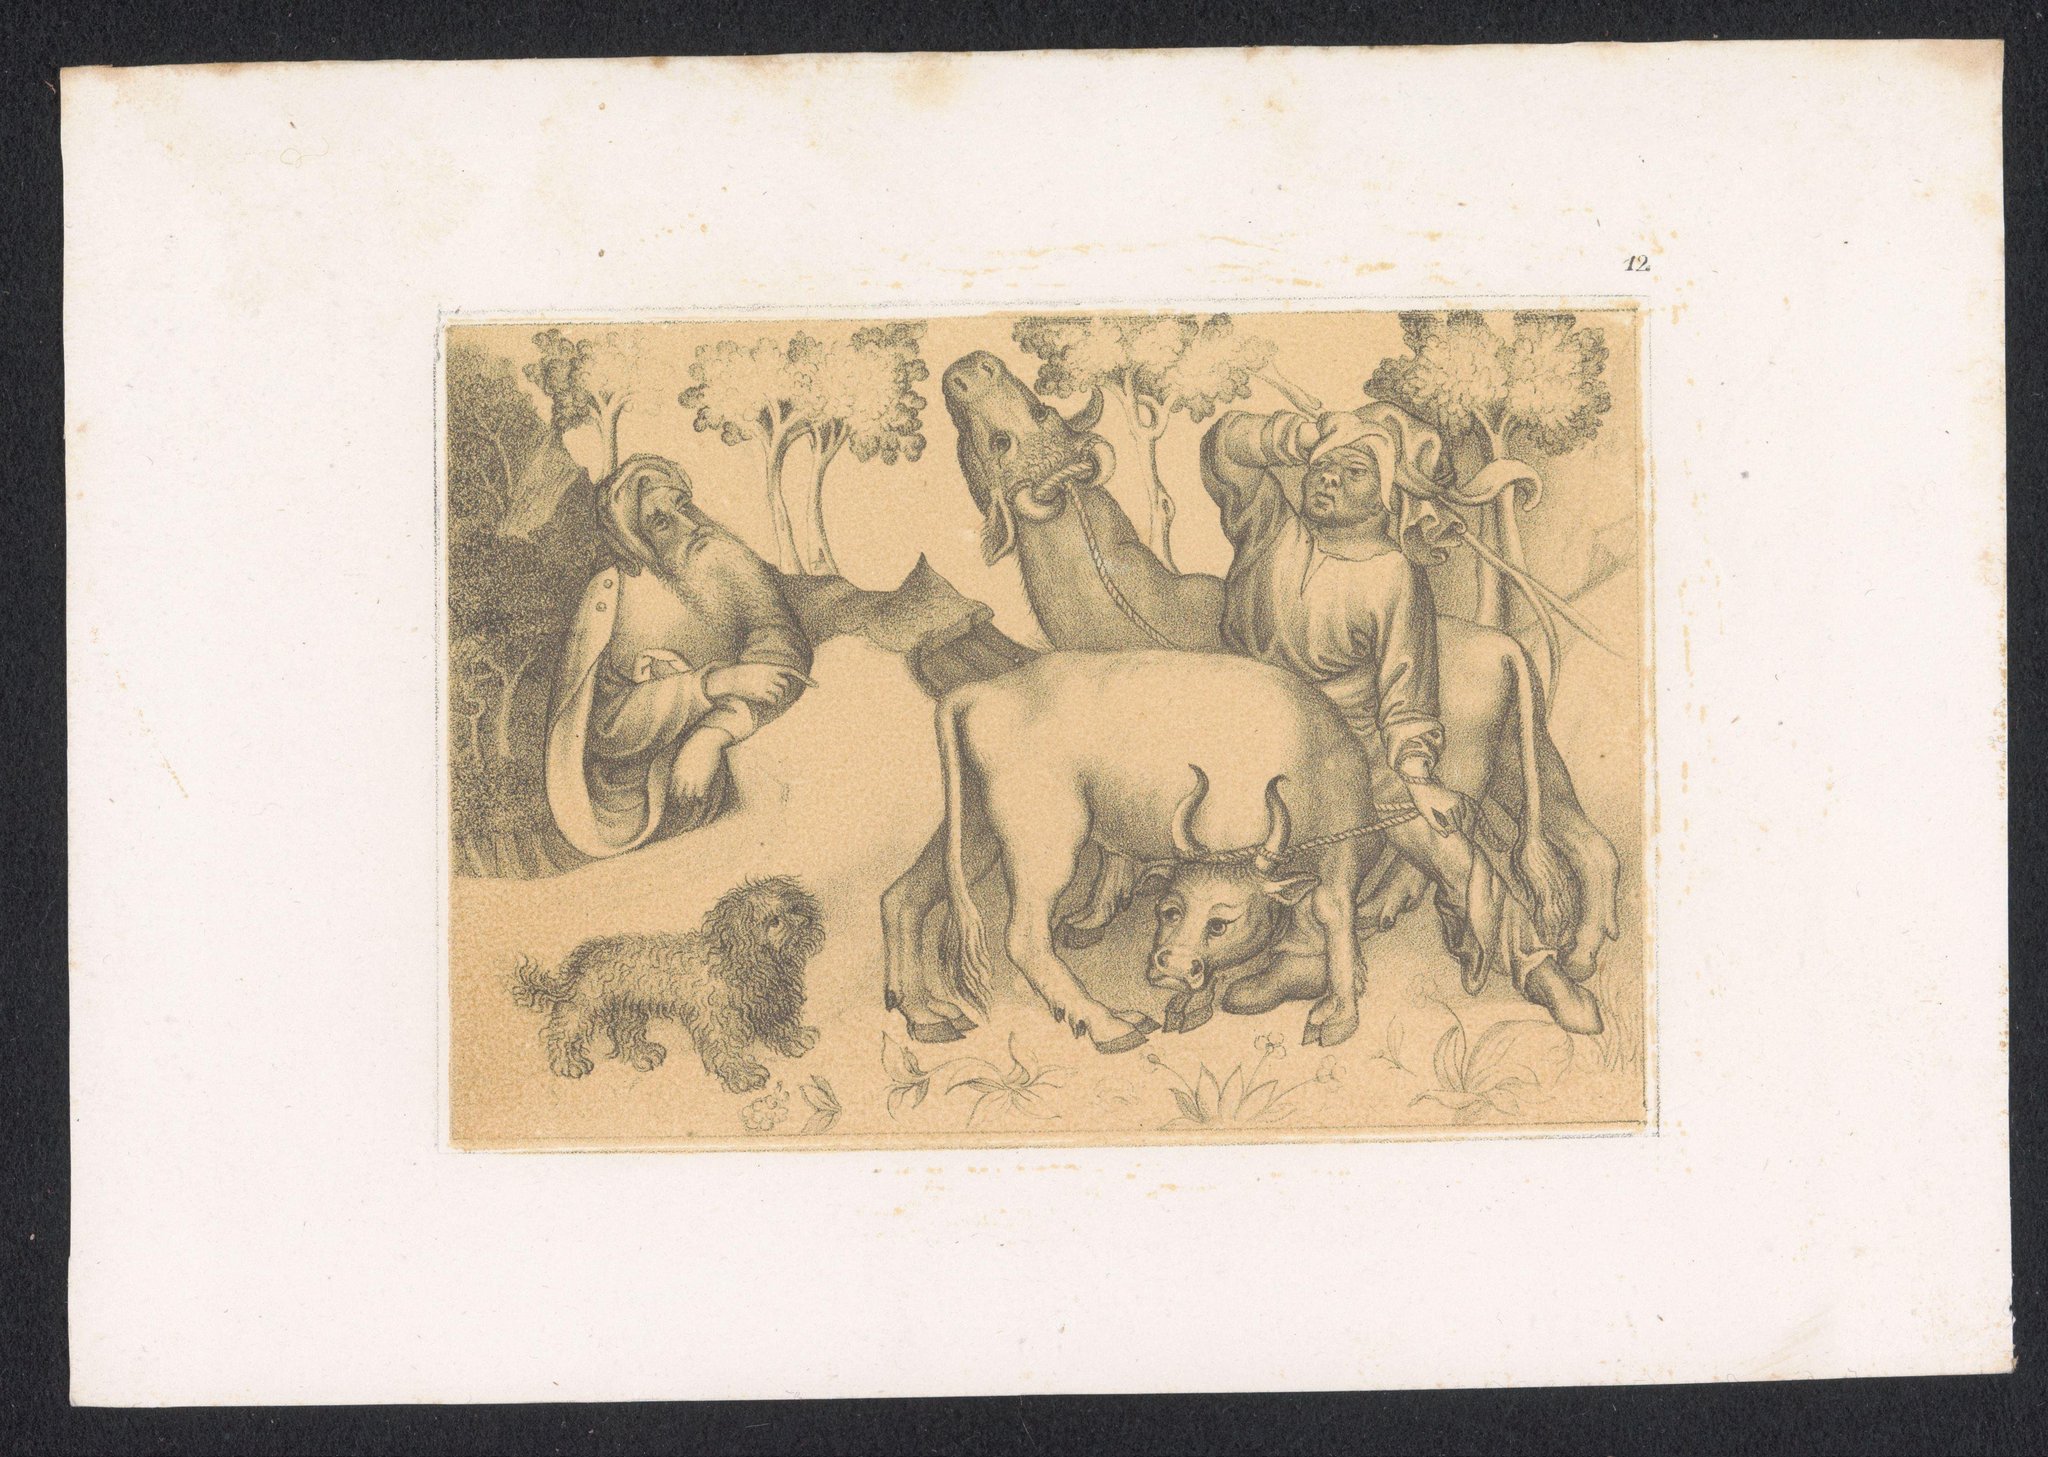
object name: print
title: Paulus van Thebe bekijkt man met twee ossen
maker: karl palzow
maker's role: print maker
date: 1830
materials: paper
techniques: tone lithography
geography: berlin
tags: ox, paul of thebes, the first hermit; possible attributes: raven, two lions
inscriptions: collector's mark: Lugt 2228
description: Een kluizenaar, vermoedelijk Paulus van Thebe, kijkt richting een man die met moeite zijn twee vastgeketende ossen vasthoudt. Een hond blaft naar de ossen. Prent is onderdeel van een omslag met tekst en een serie van achttien lithografieën naar schilderijen van Nederlandse meesters.